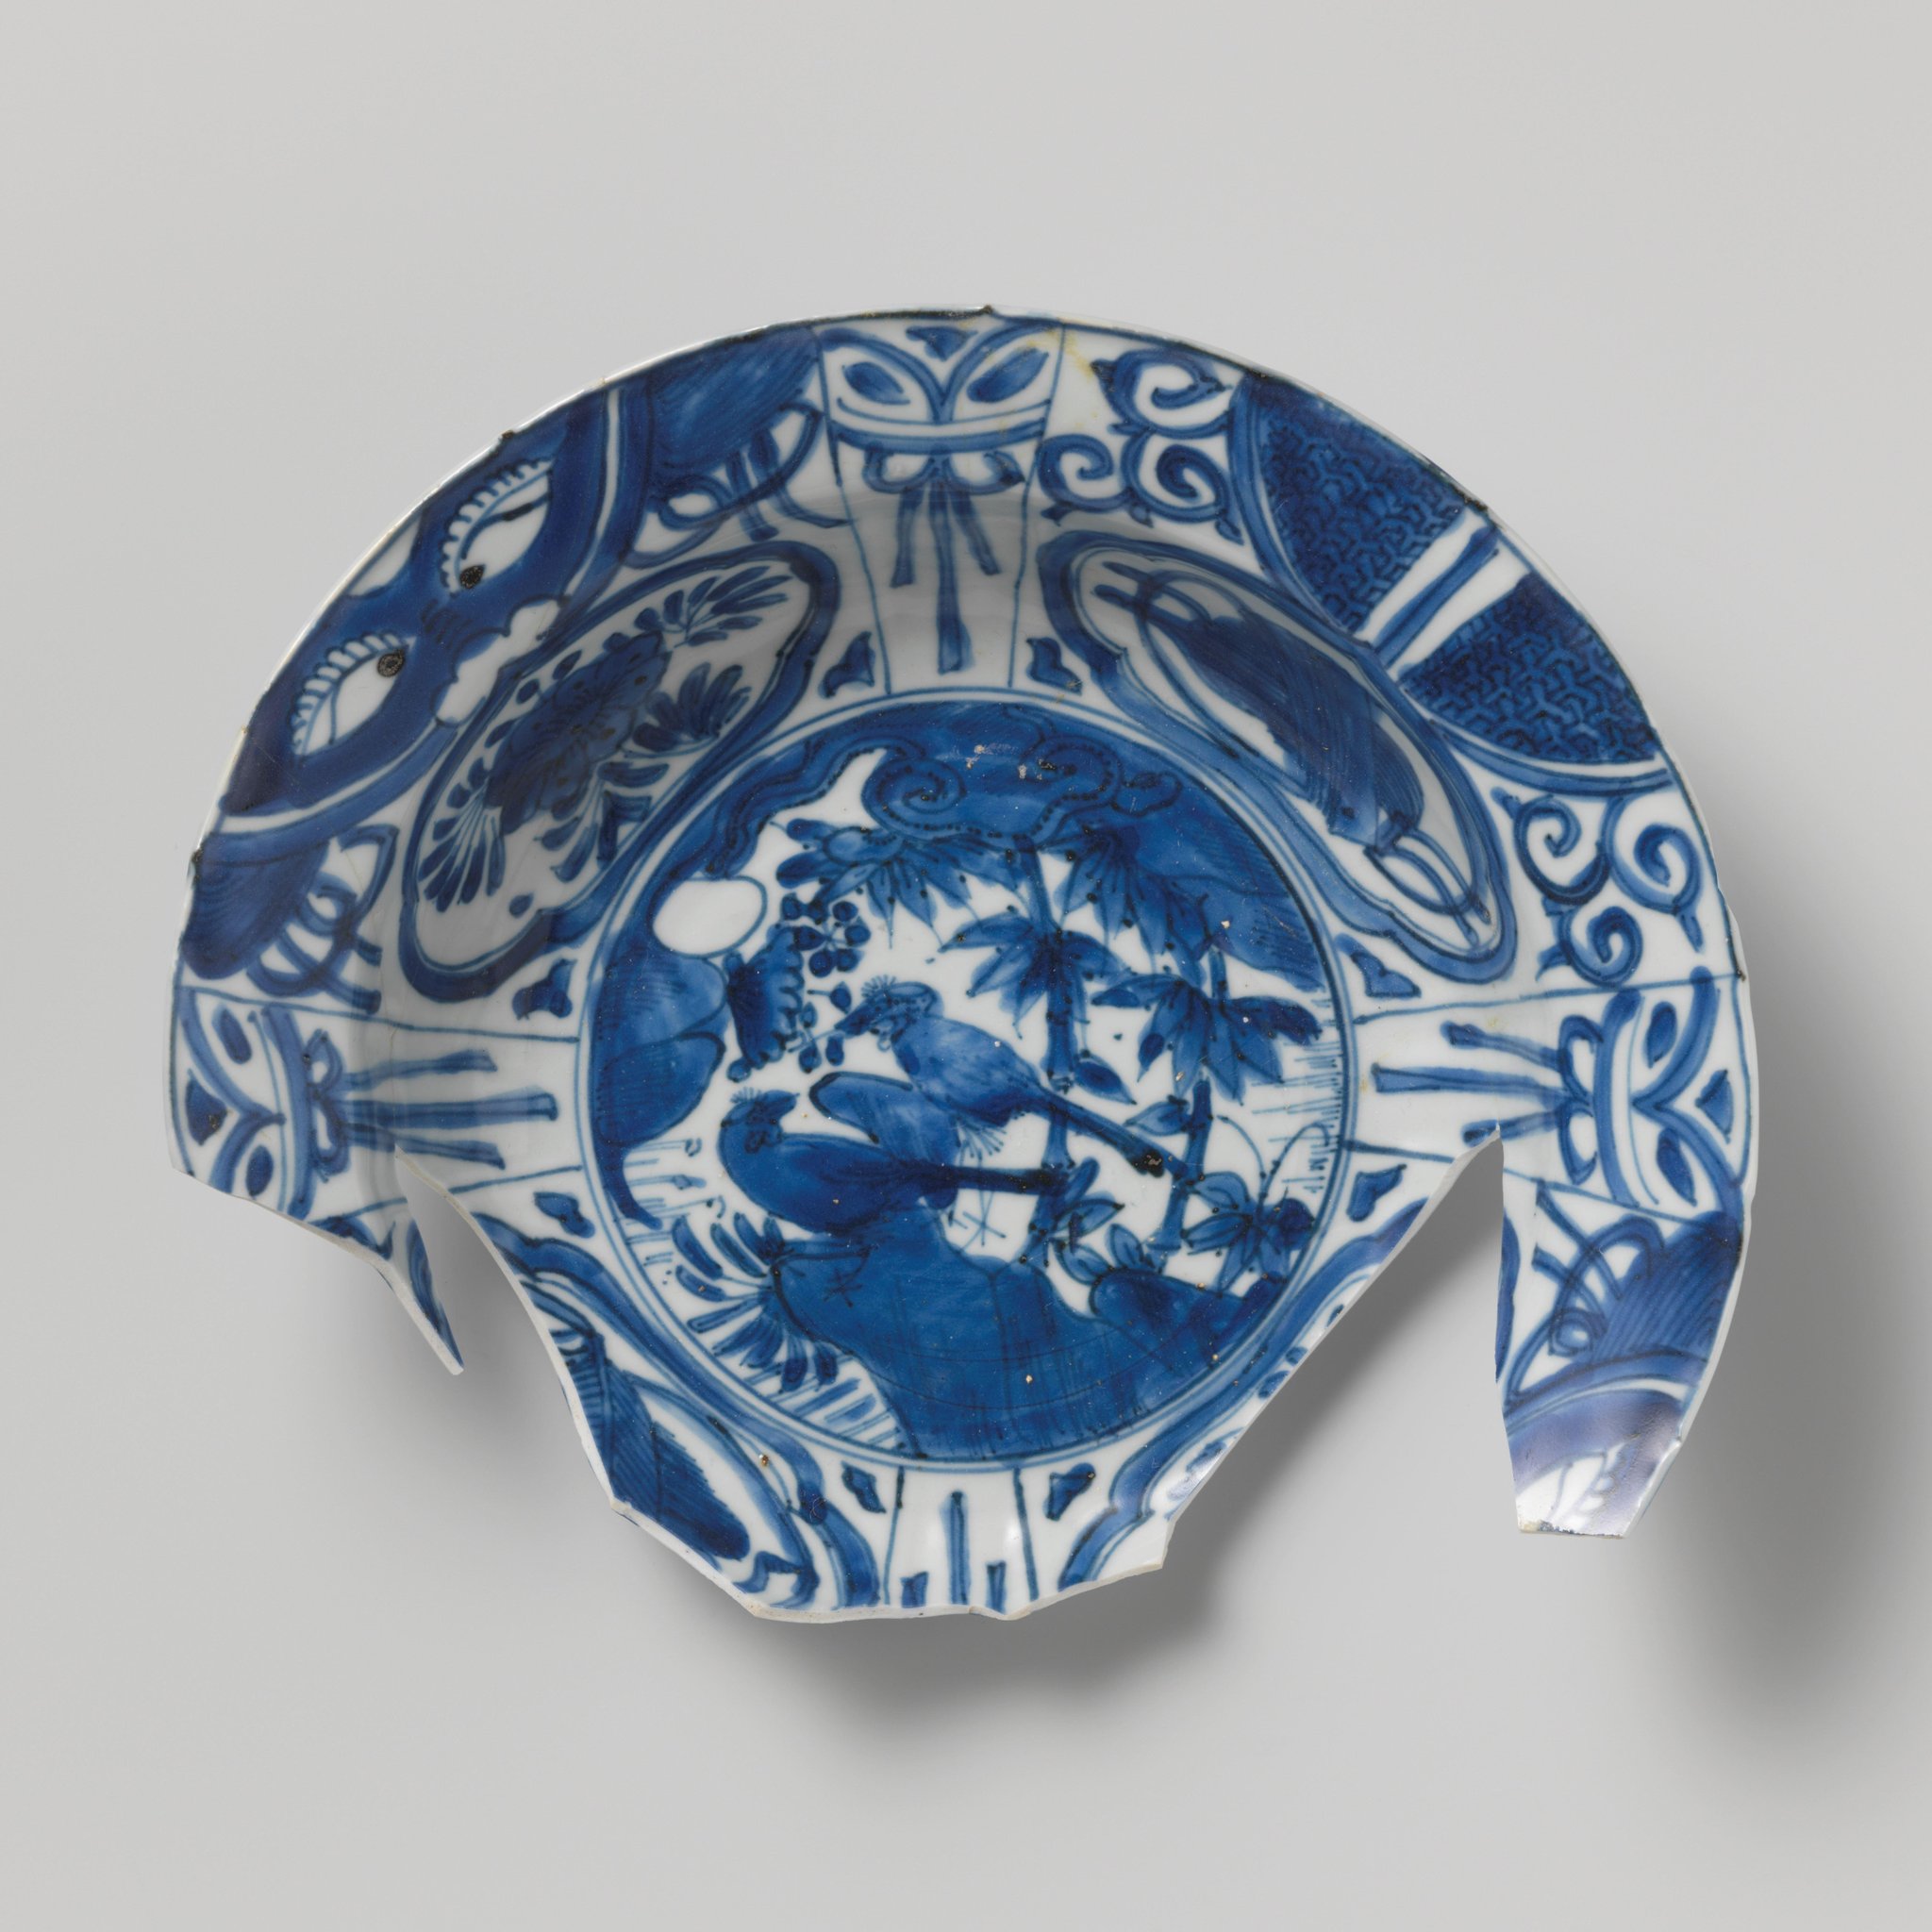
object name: plate dish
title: Fragment diep bord uit V.O.C.-schip de 'Witte Leeuw'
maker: Anonymous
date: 1613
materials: bone china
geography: jingdezhen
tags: verenigde oostindische compagnie, sint-helena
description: A bowl with a flattened rim. Taotie mask and/or borders with diaper patterns. A central decoration of a bird on a rock next to abamboo. Panels decorated with flowers and symbols.